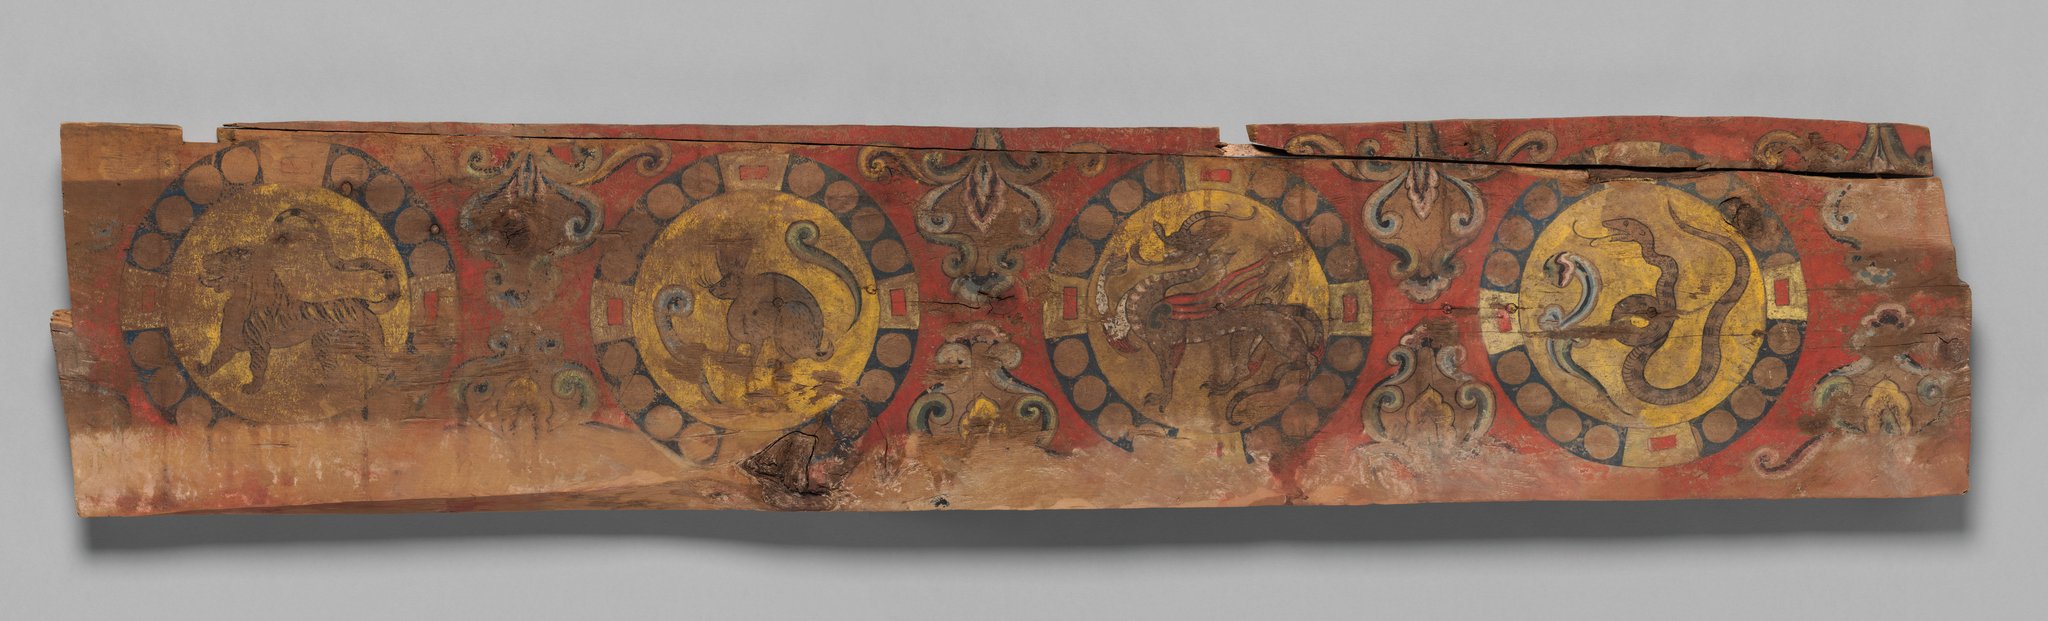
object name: panel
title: Panel with Chinese Zodiac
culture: central asian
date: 701-900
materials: pigment, wood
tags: dragons,rabbits,serpents,tigers,zodiac